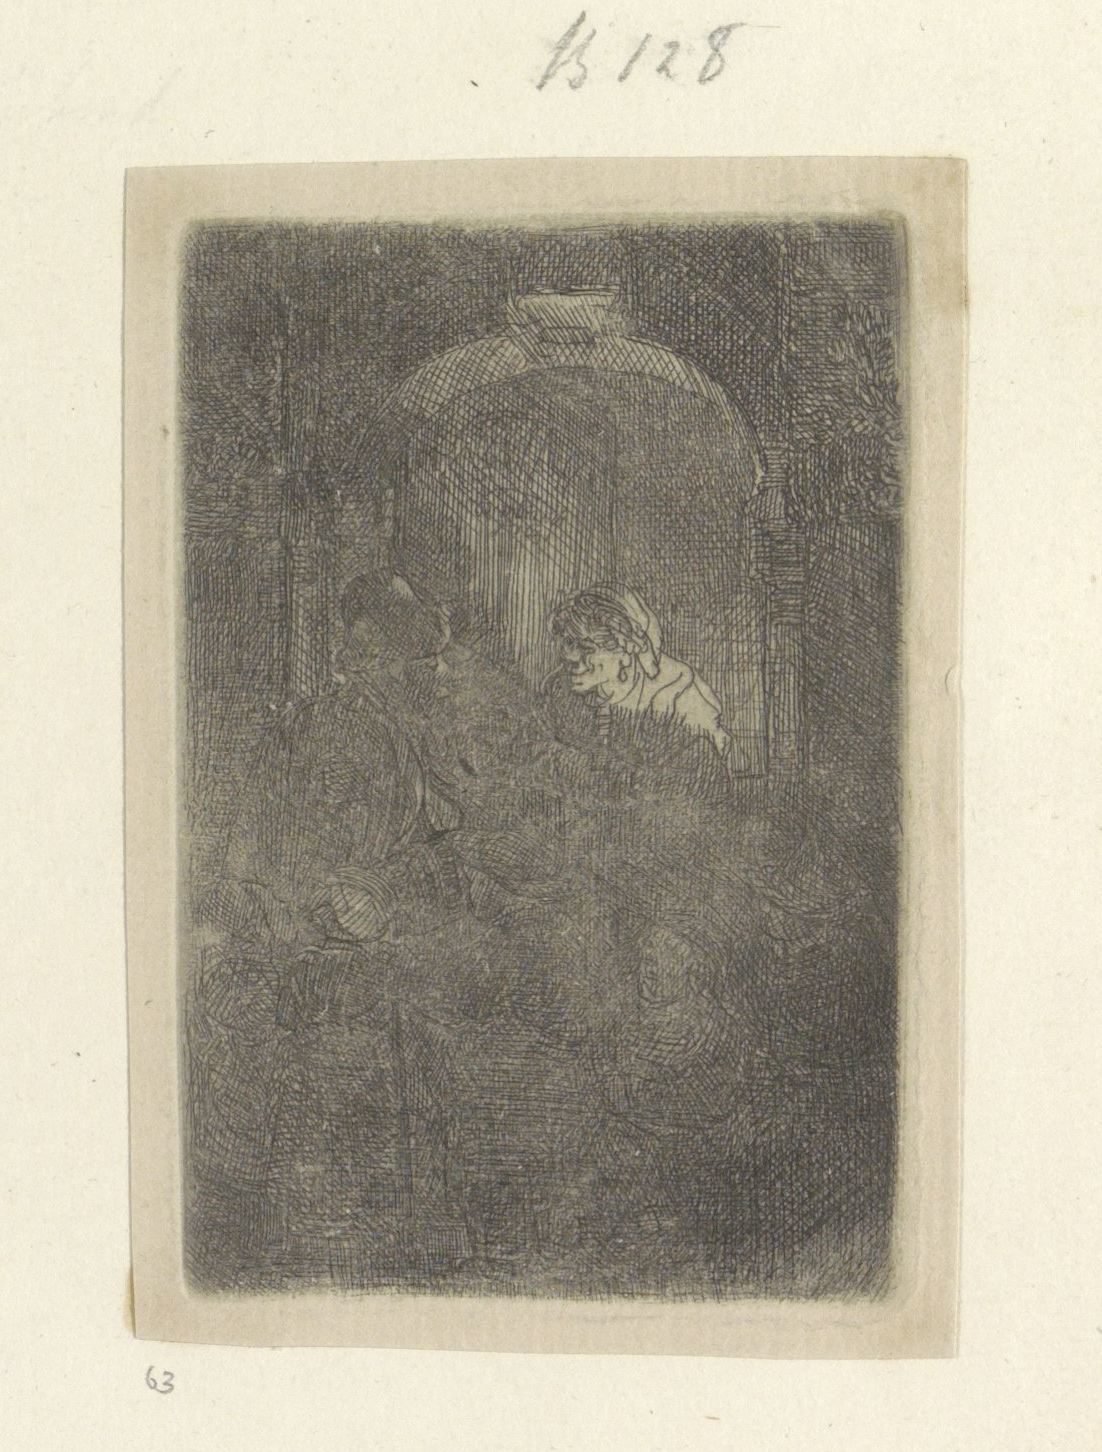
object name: album leaf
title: Vrouw in een deuropening, pratend met een man met kinderen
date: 1641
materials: paper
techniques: etching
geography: paris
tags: child teaching teacher, parents, or other adults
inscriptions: date